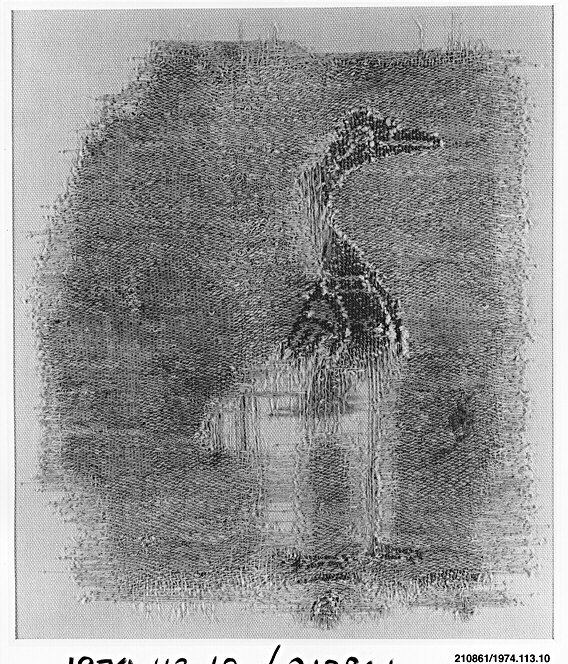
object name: textile fragment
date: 901-1100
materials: cotton, wool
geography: iran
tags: birds